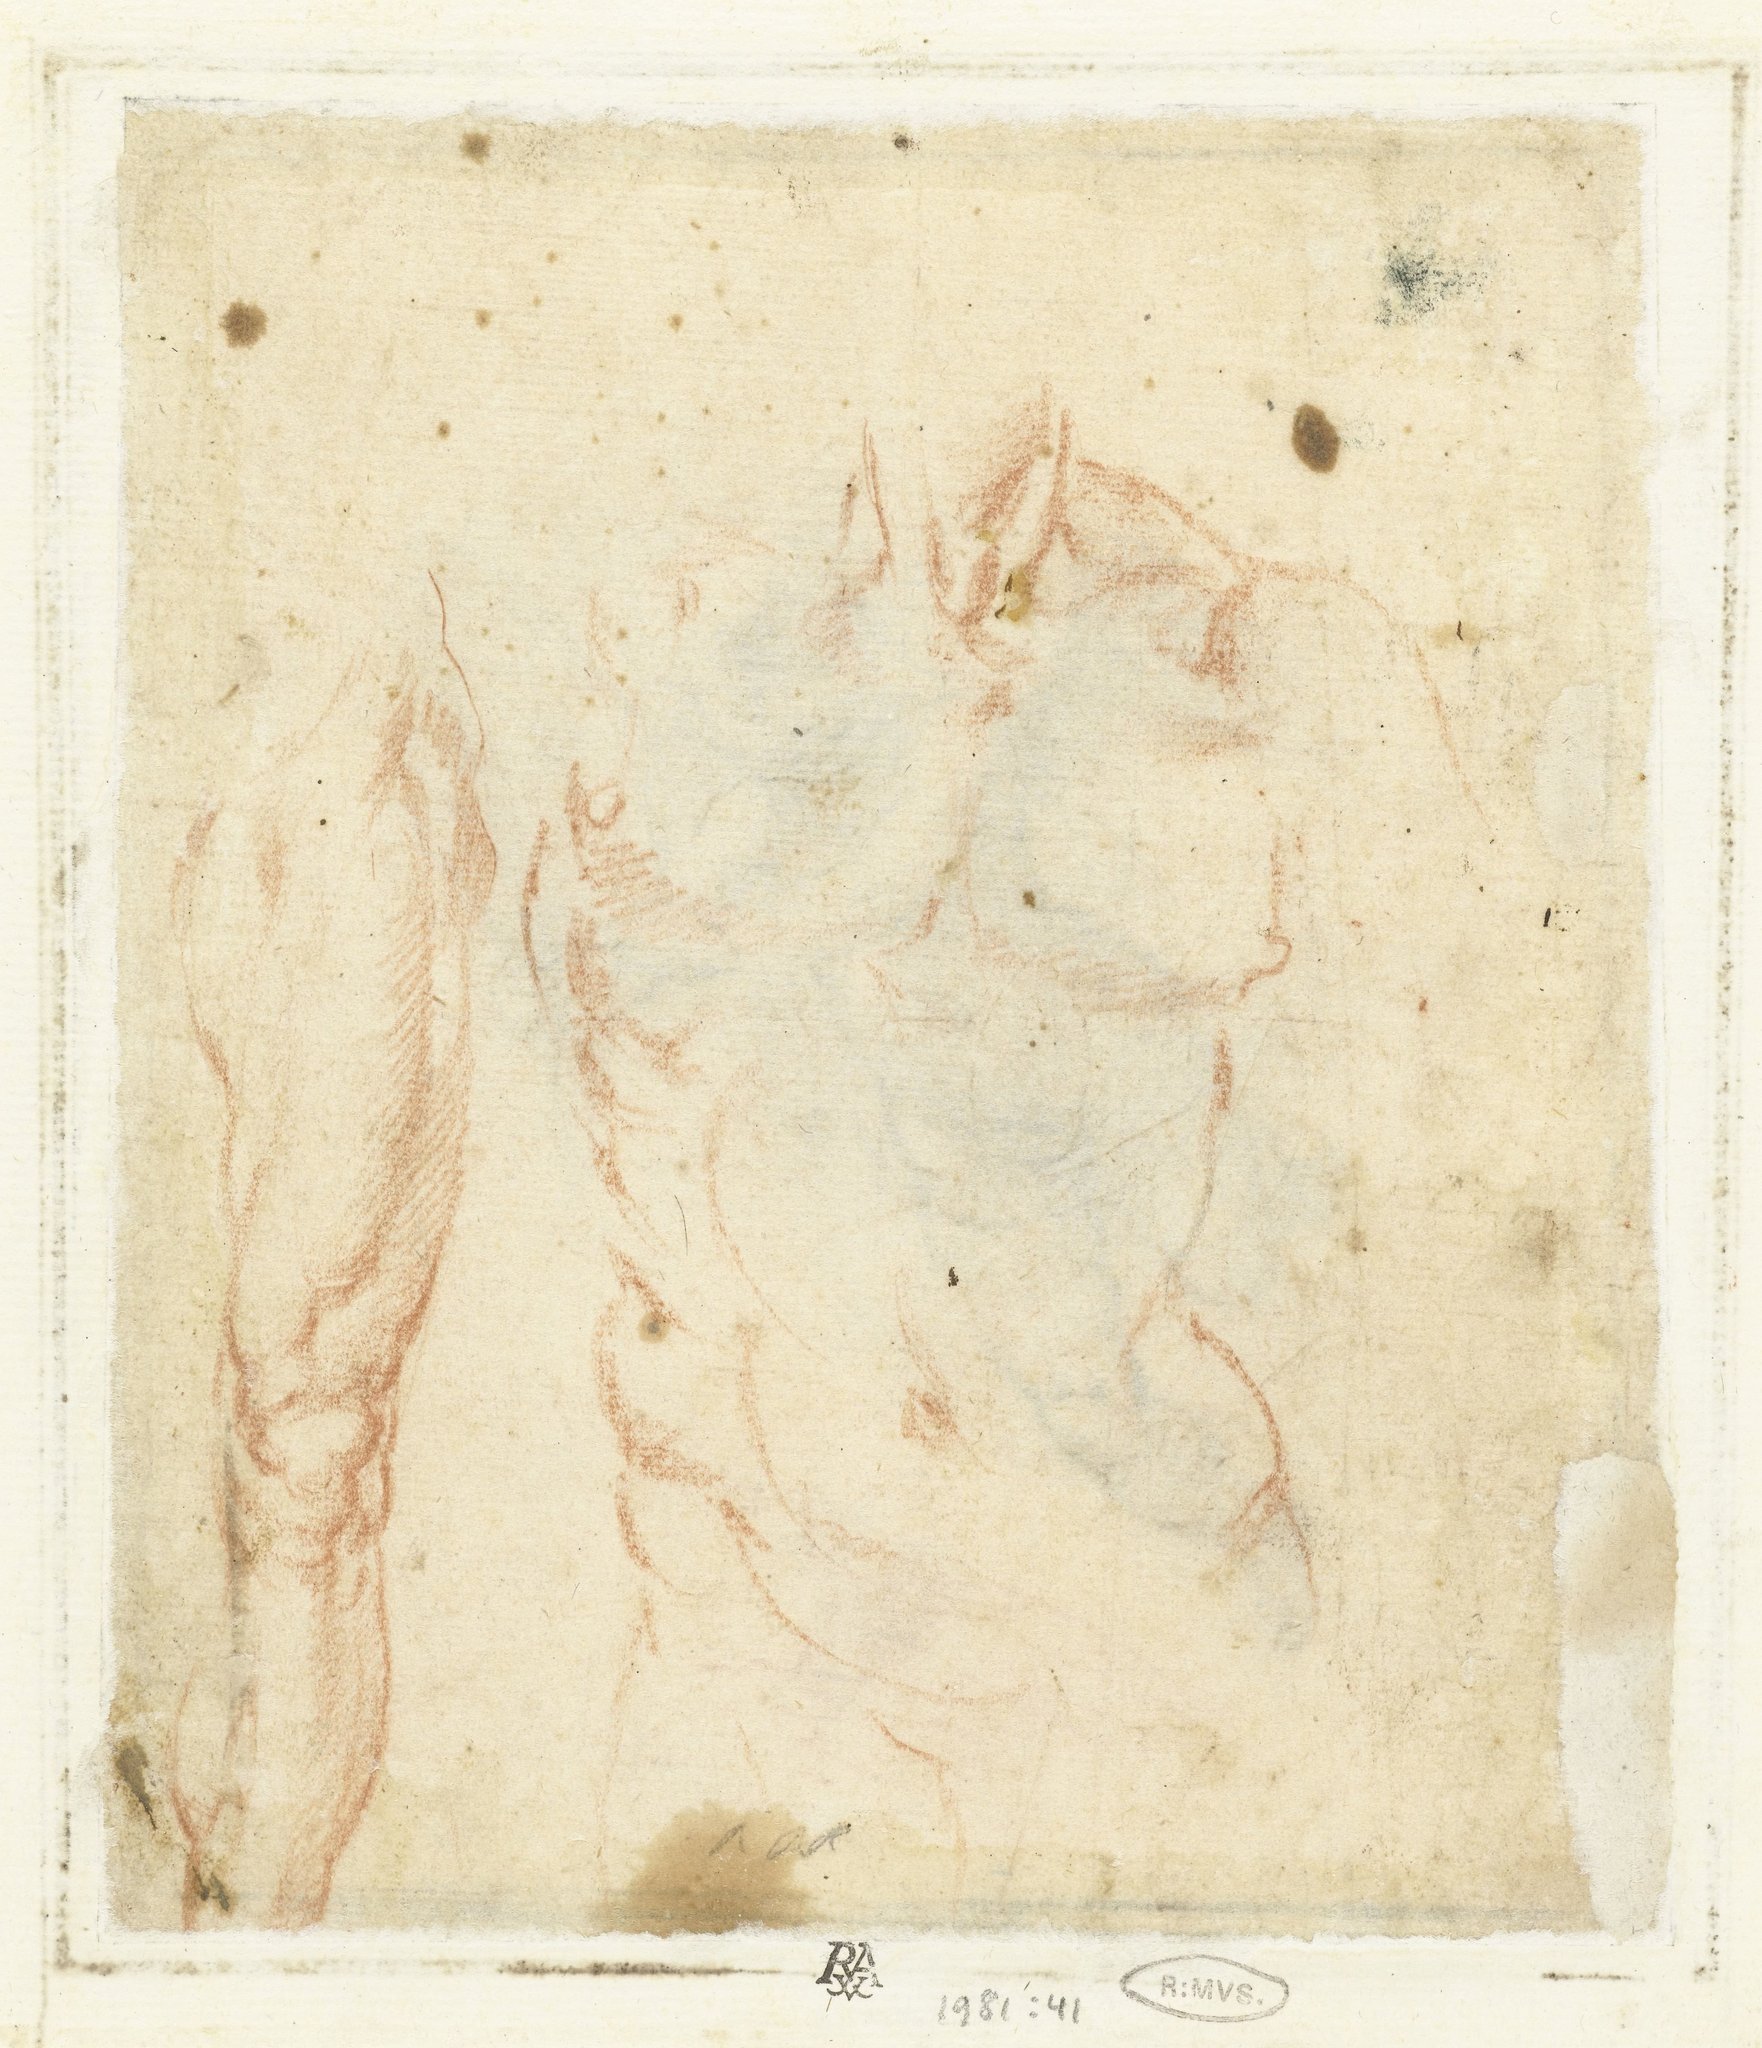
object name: drawing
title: Mannelijk torso en been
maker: bernardino poccetti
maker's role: draughtsman, painter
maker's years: 1545-1612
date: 1558-1612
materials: chalk, paper